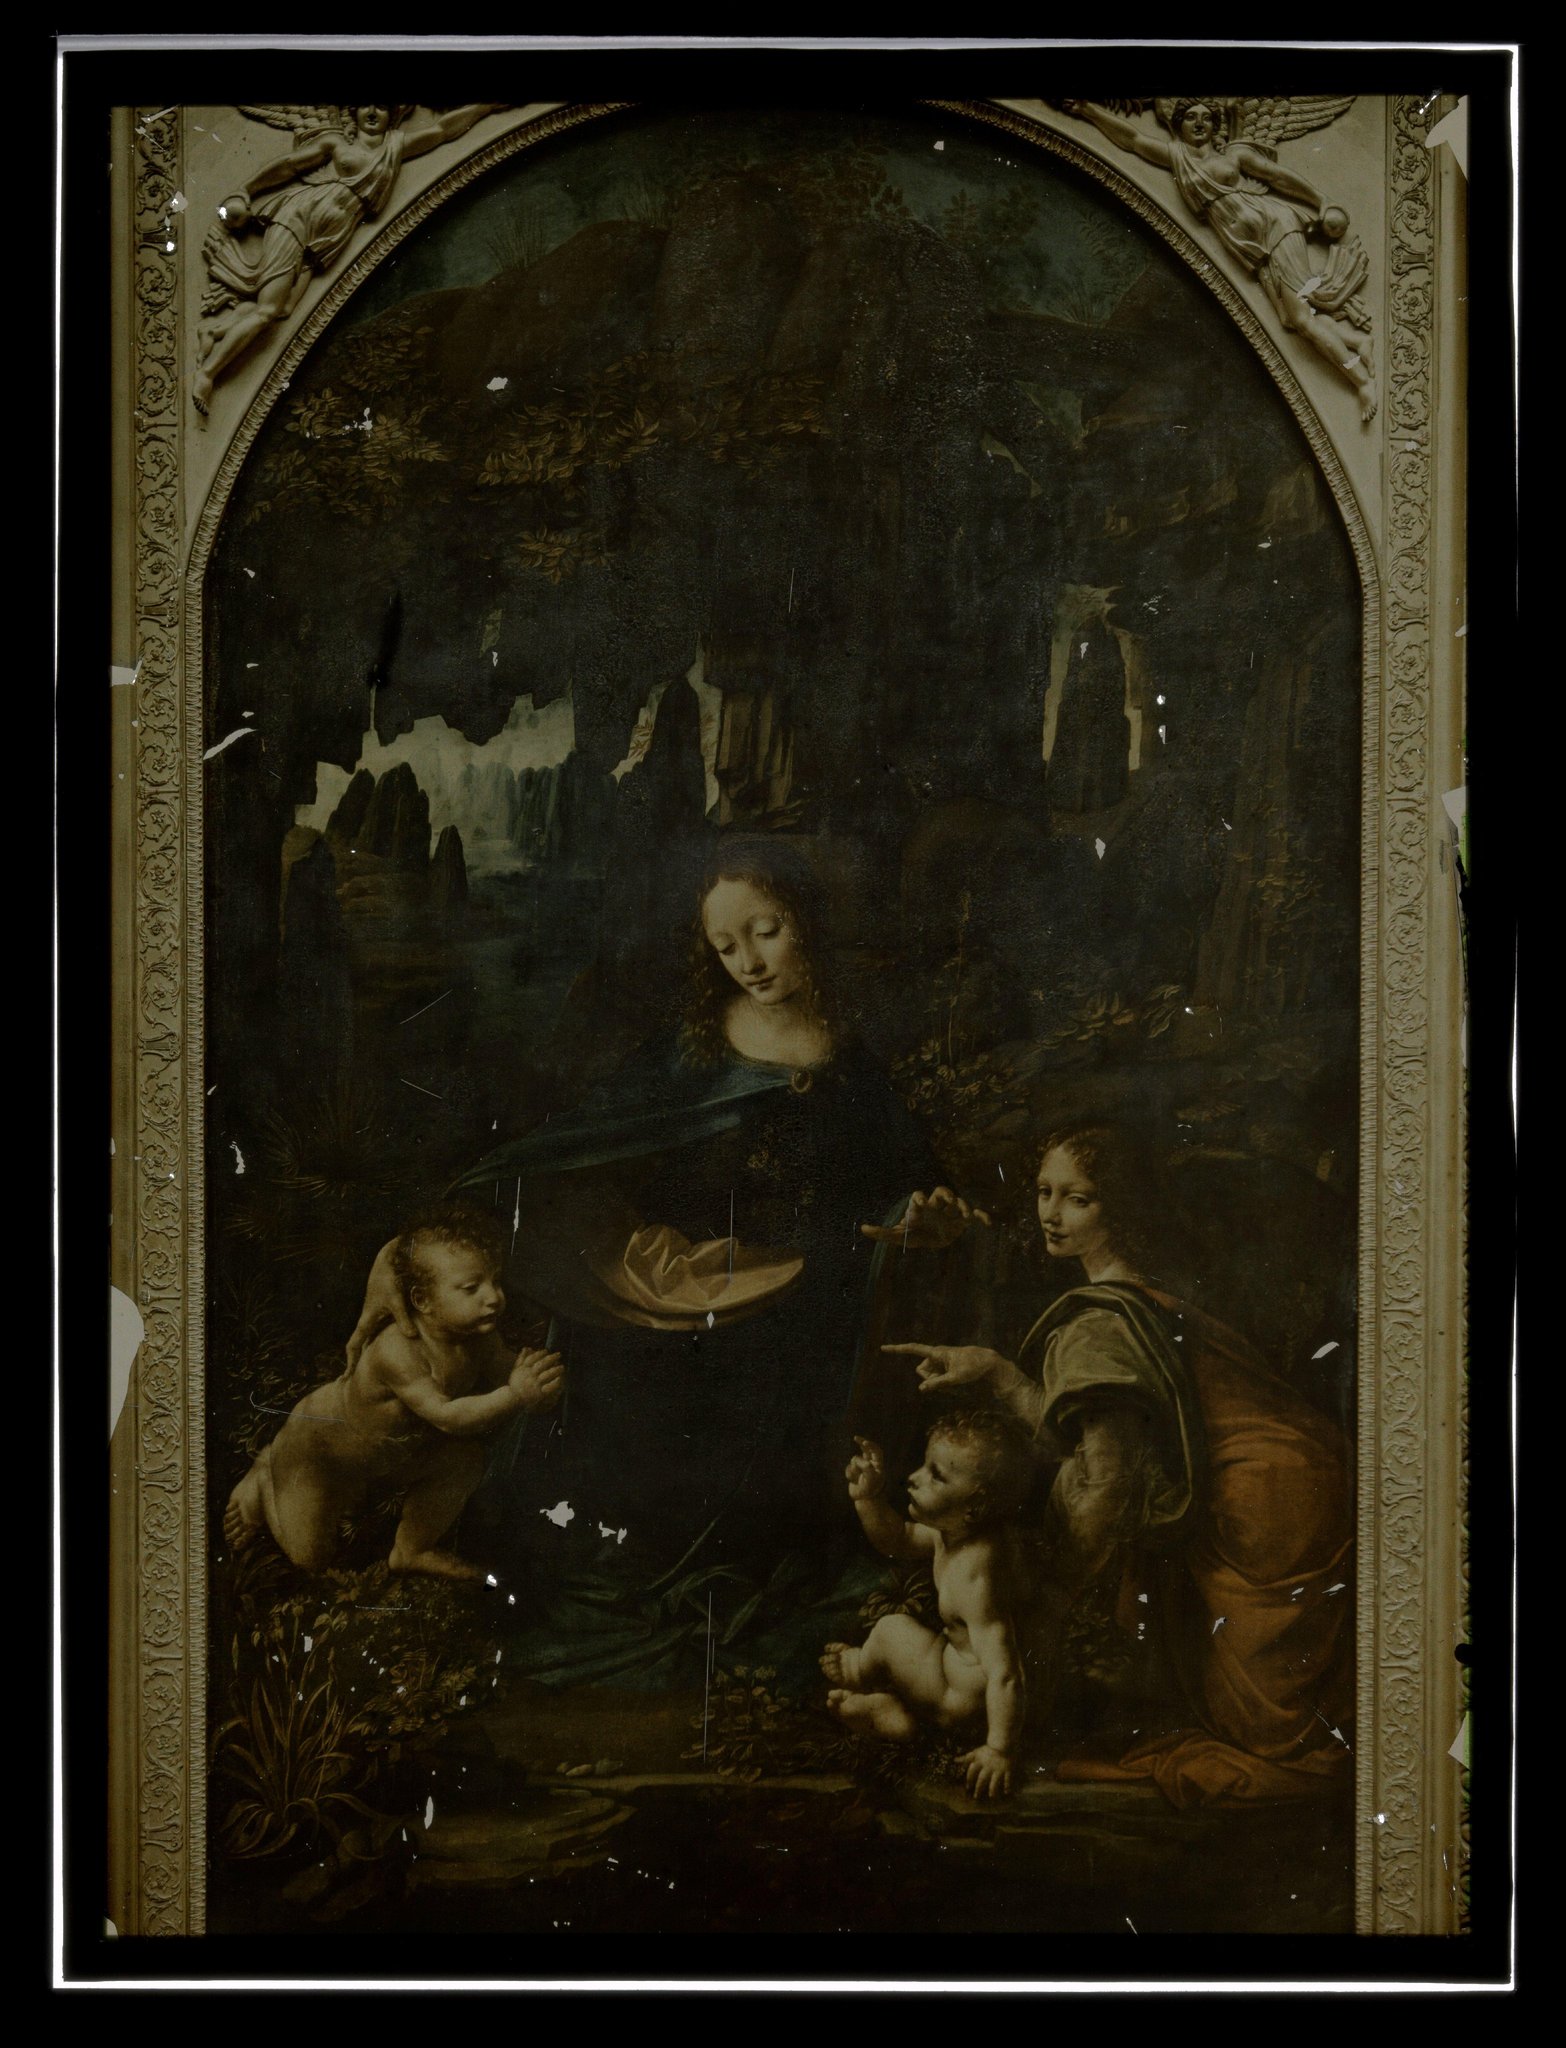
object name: photograph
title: Reproductie van Leonardo da Vinci, Maagd op de rotsen, Louvre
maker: Anonymous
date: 1907-1935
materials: glass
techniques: autochrome process, slide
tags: picture, painting